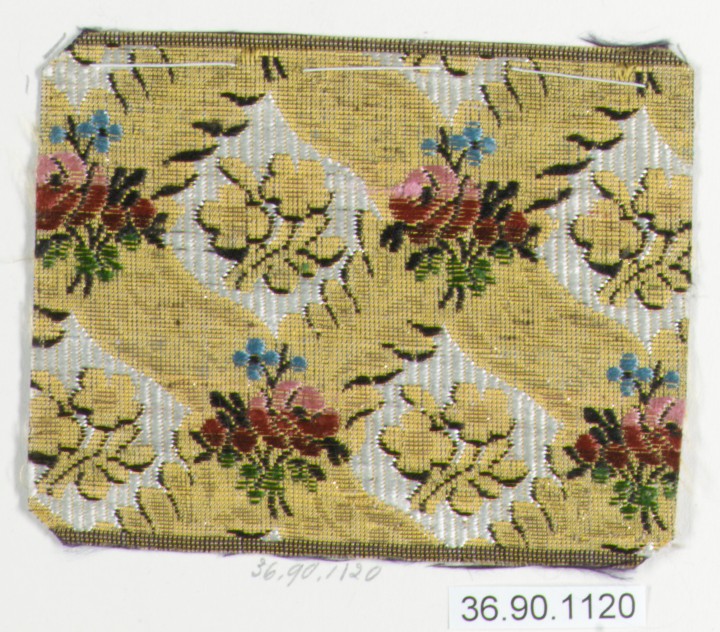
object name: sample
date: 1701-1900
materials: metal thread, silk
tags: flowers